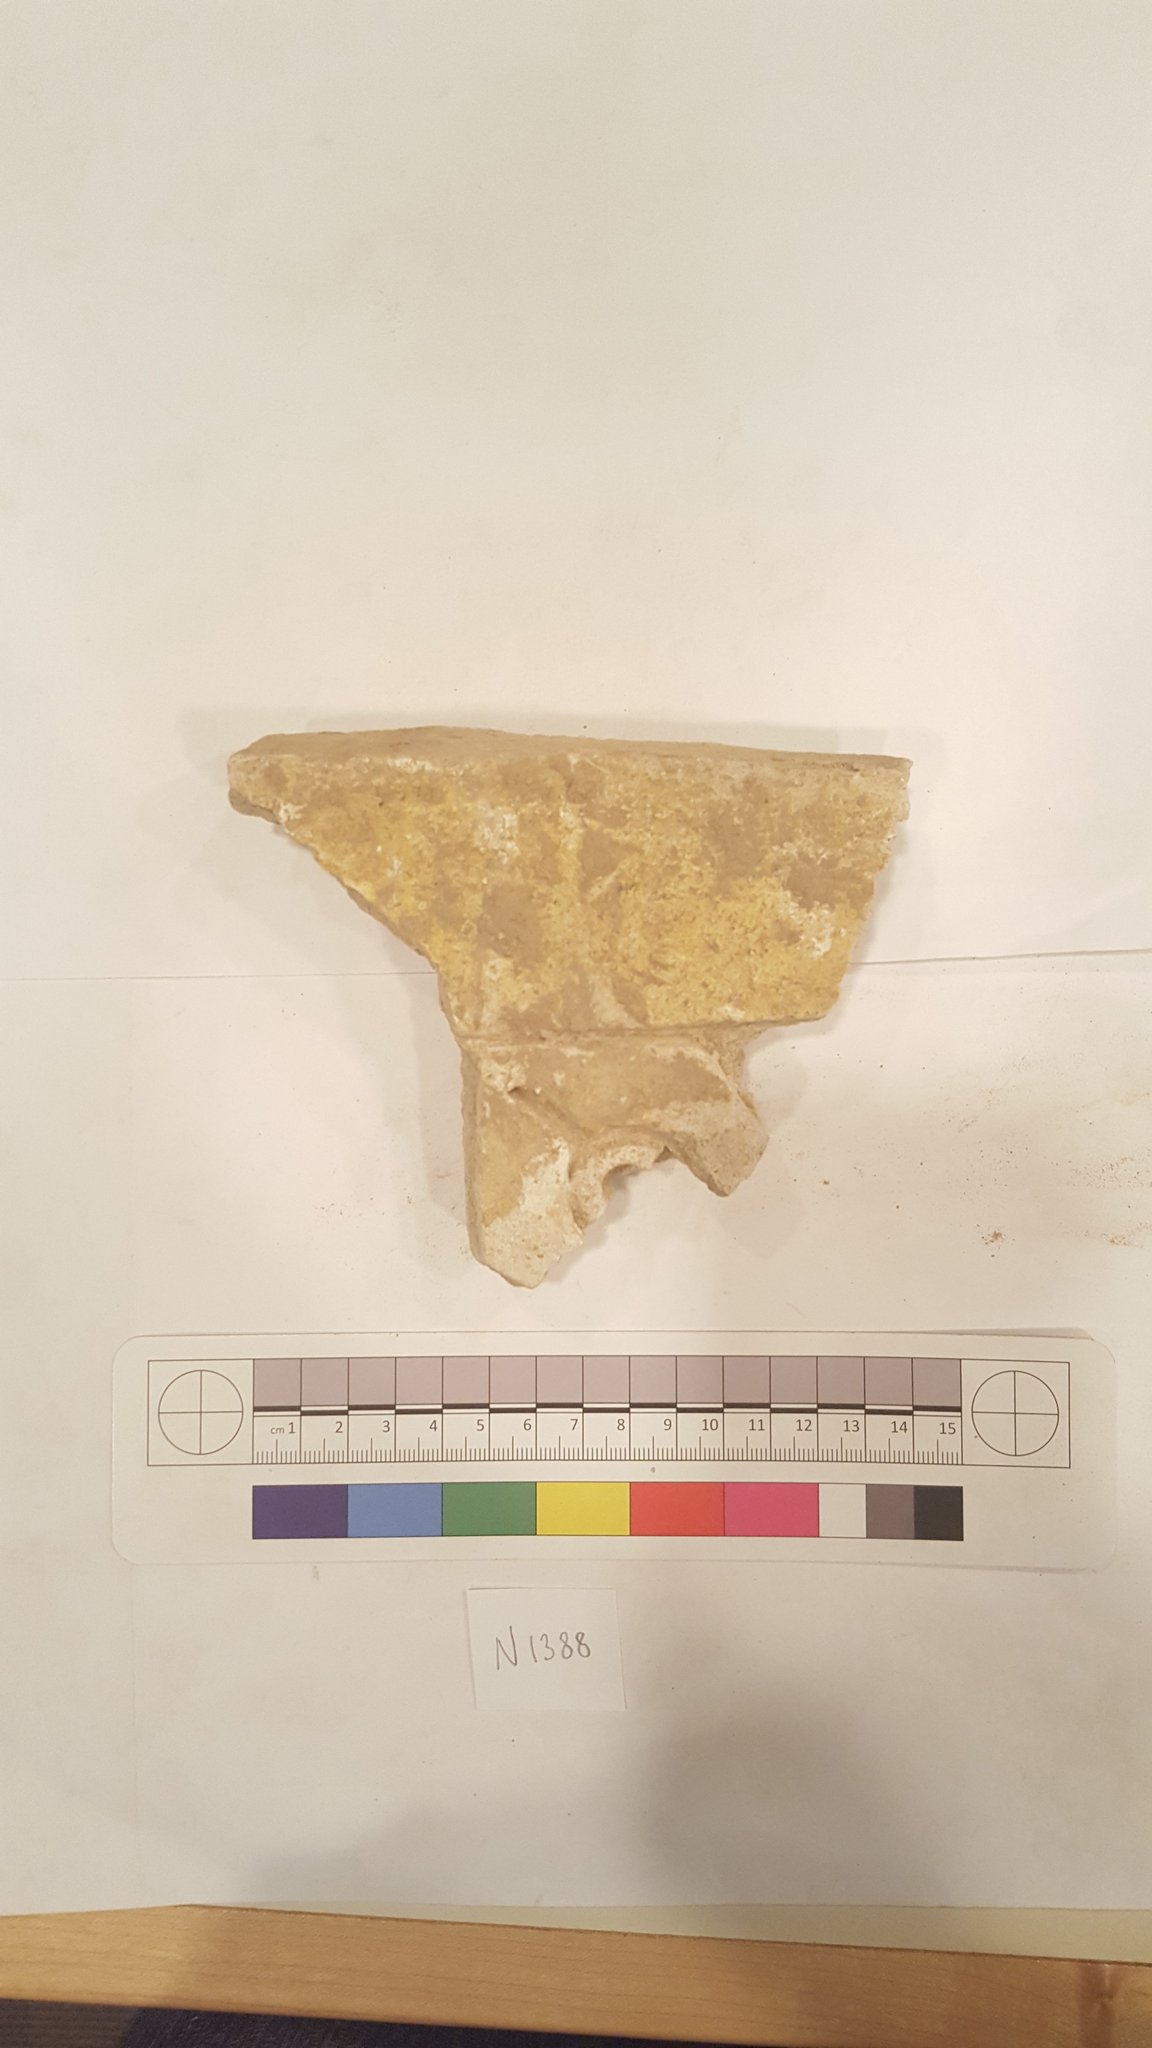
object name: fragment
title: Stucco Fragment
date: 701-1200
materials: plaster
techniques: carving, painting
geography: iran